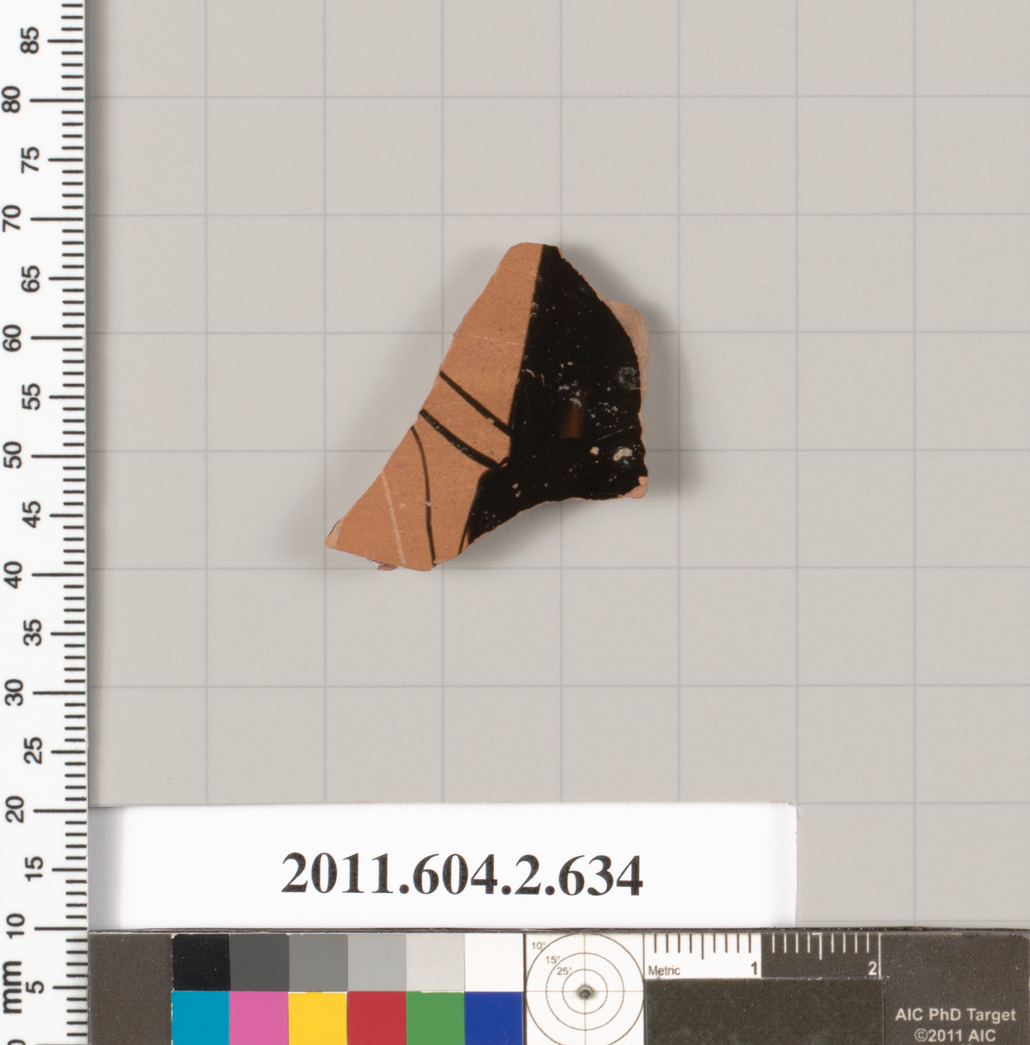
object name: column krater fragment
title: Terracotta fragment of a column-krater (bowl for mixing wine and water)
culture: greek, attic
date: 460-440 BCE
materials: terracotta